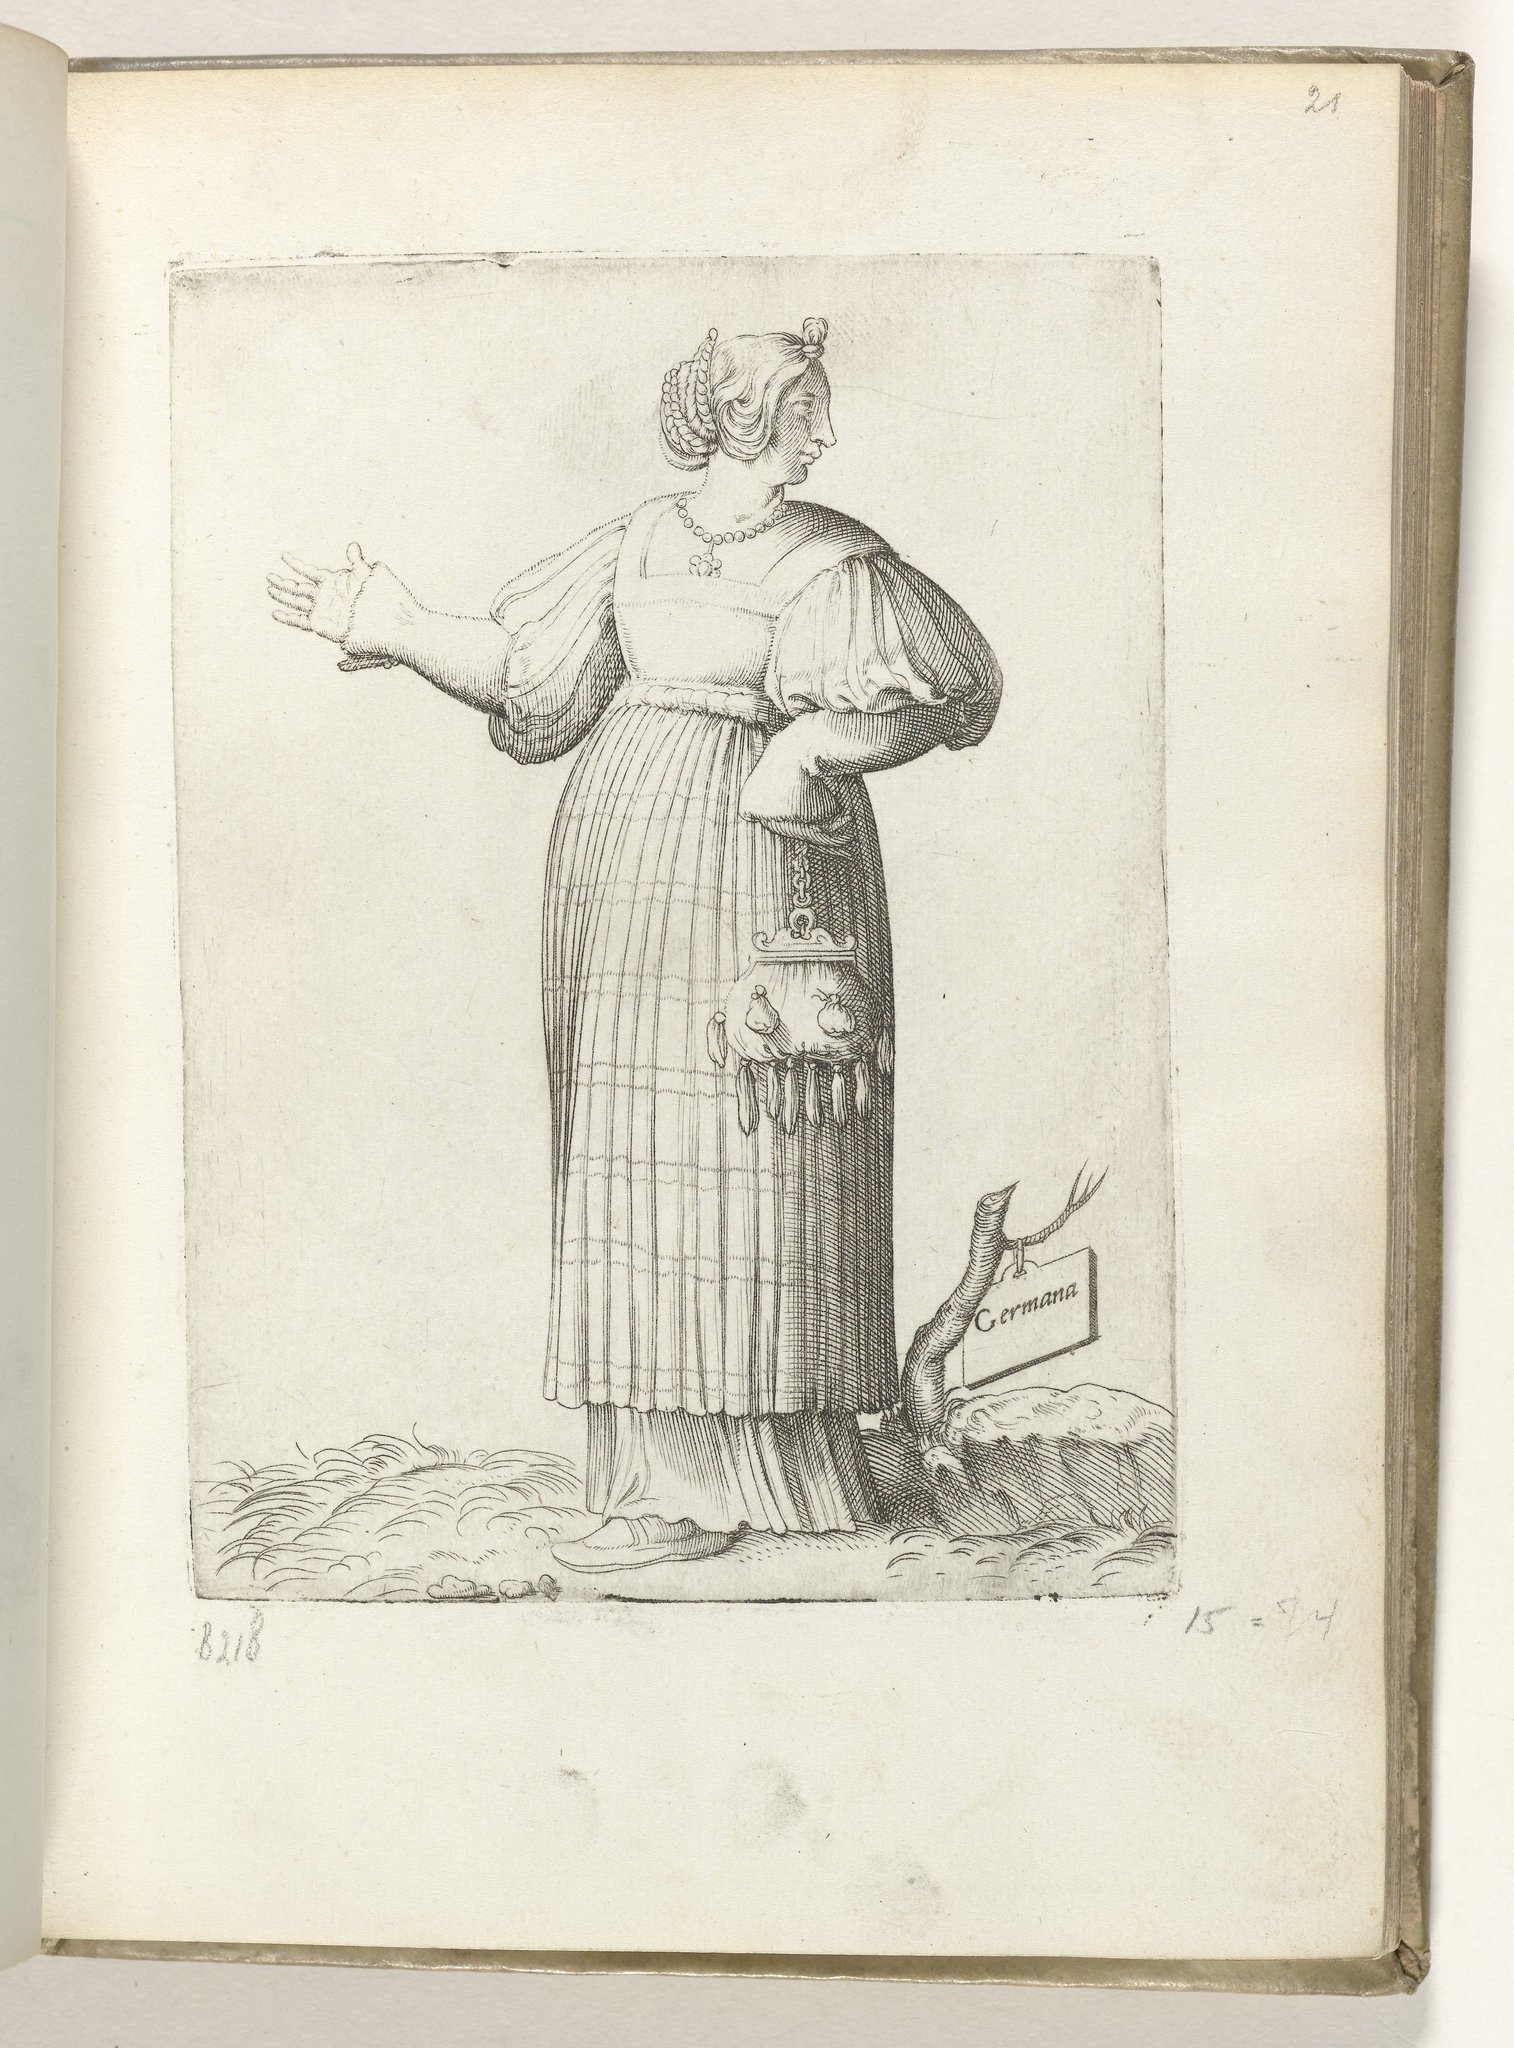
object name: costume print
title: Vrouw gekleed volgens de Duitse mode ca 1550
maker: enea vico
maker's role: draughtsman, print maker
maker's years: 1523-1567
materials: paper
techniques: engraving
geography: venice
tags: bag (+ women's clothes), fashion plates, europeans (swiss) (+ costume), belt, girdle, waistband (+ women's clothes)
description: Duitse vrouw, naar links, een buidel met kwastjes, die aan haar gordel hangt, in de linkerhand houdend. Prent uit album 'Diversarum gentium nostrae aetatis habitus'.